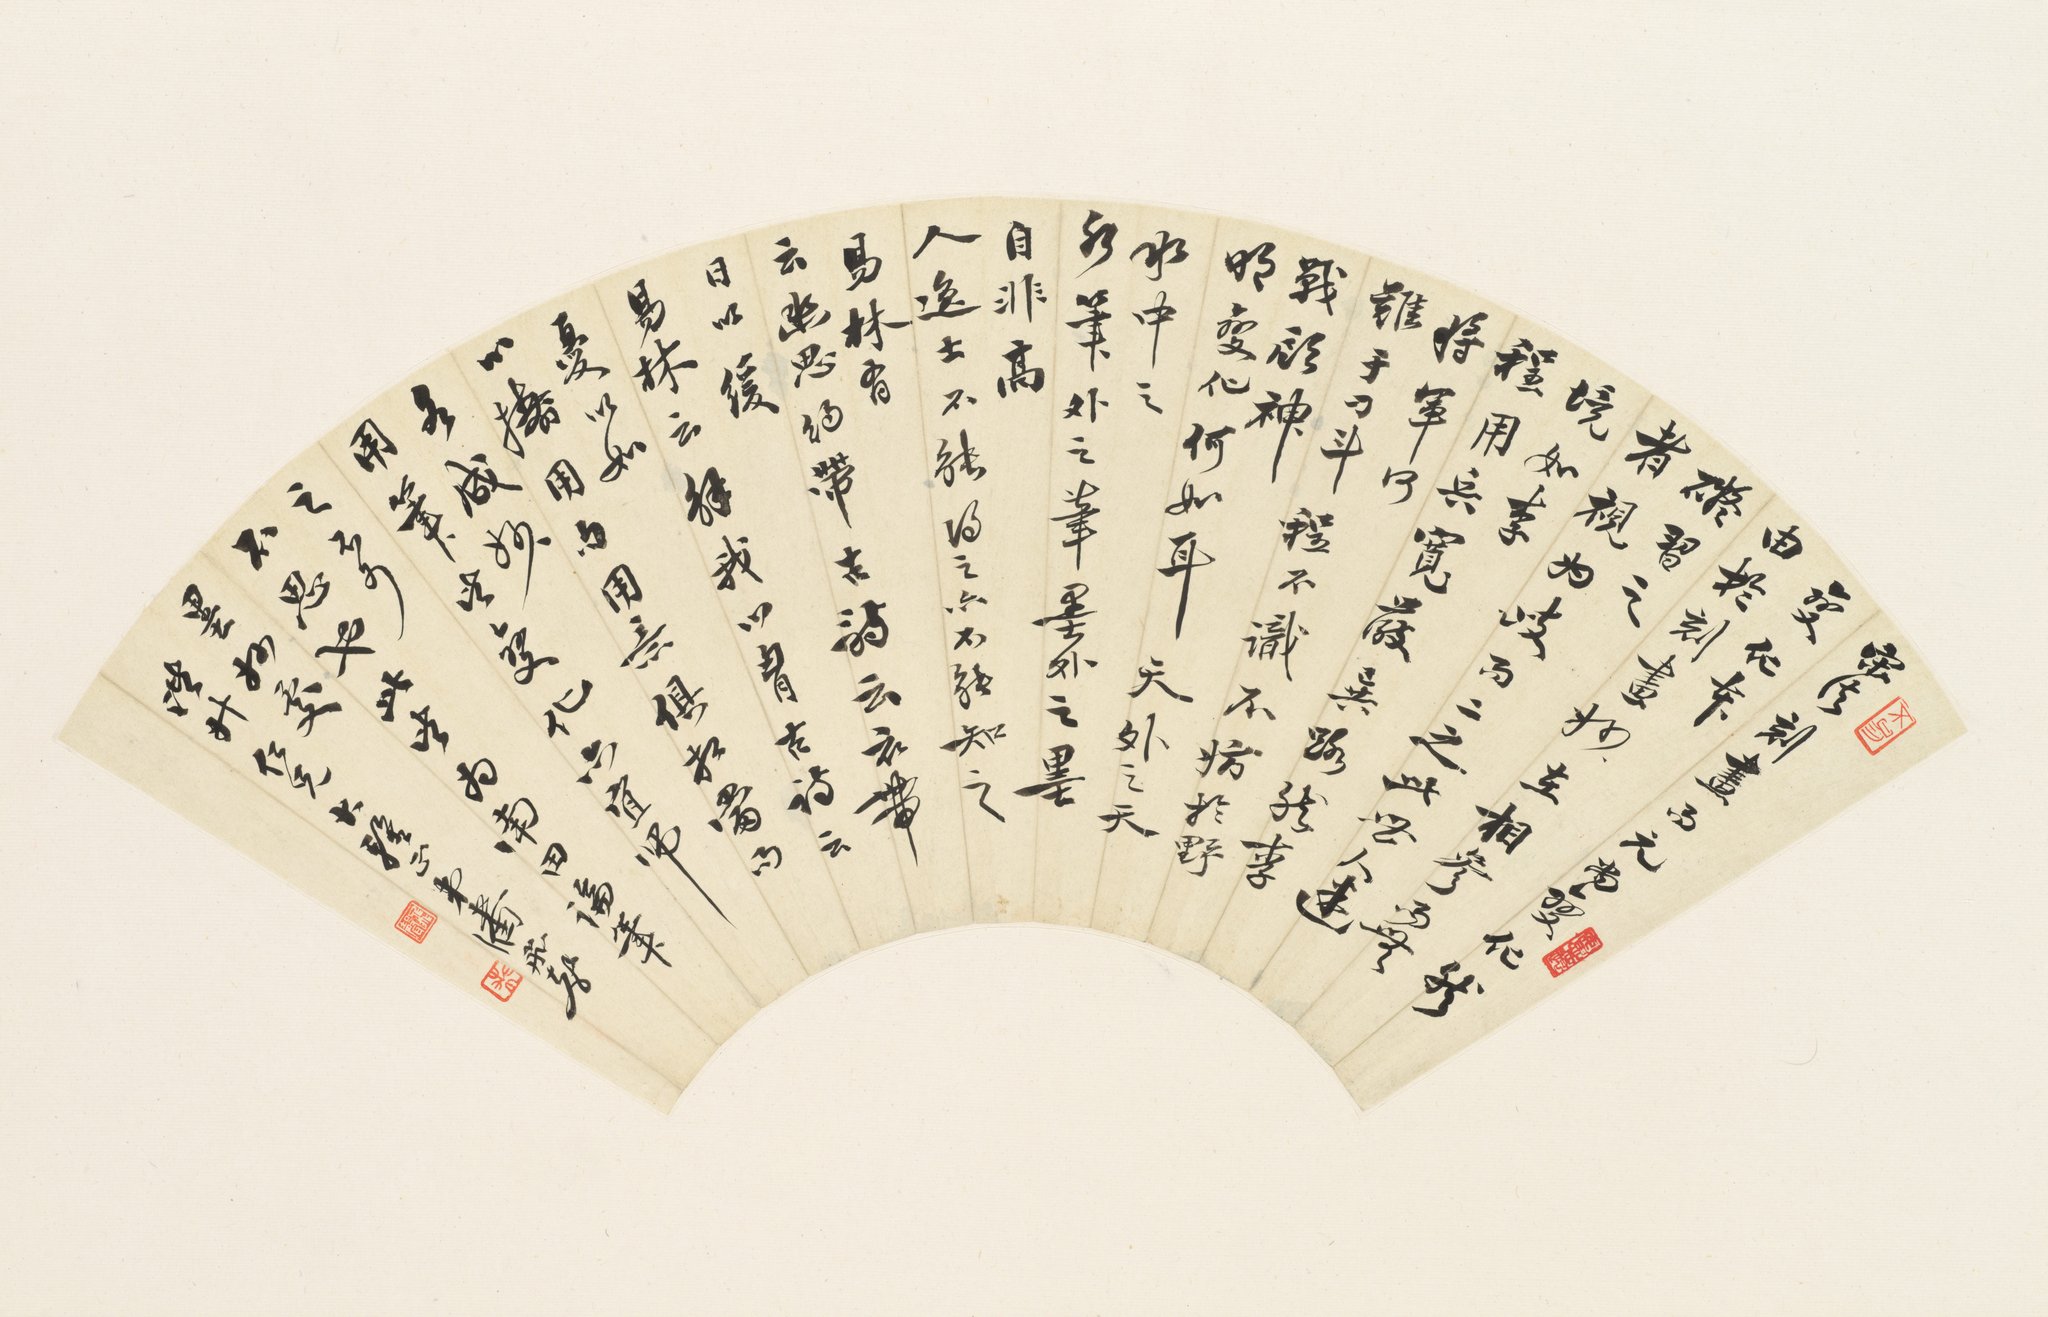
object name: folding fan mounted a an album leaf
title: Yun Shouping's Discussion on Brushwork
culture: chinese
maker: pan feisheng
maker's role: artist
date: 1901-2000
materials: ink, paper